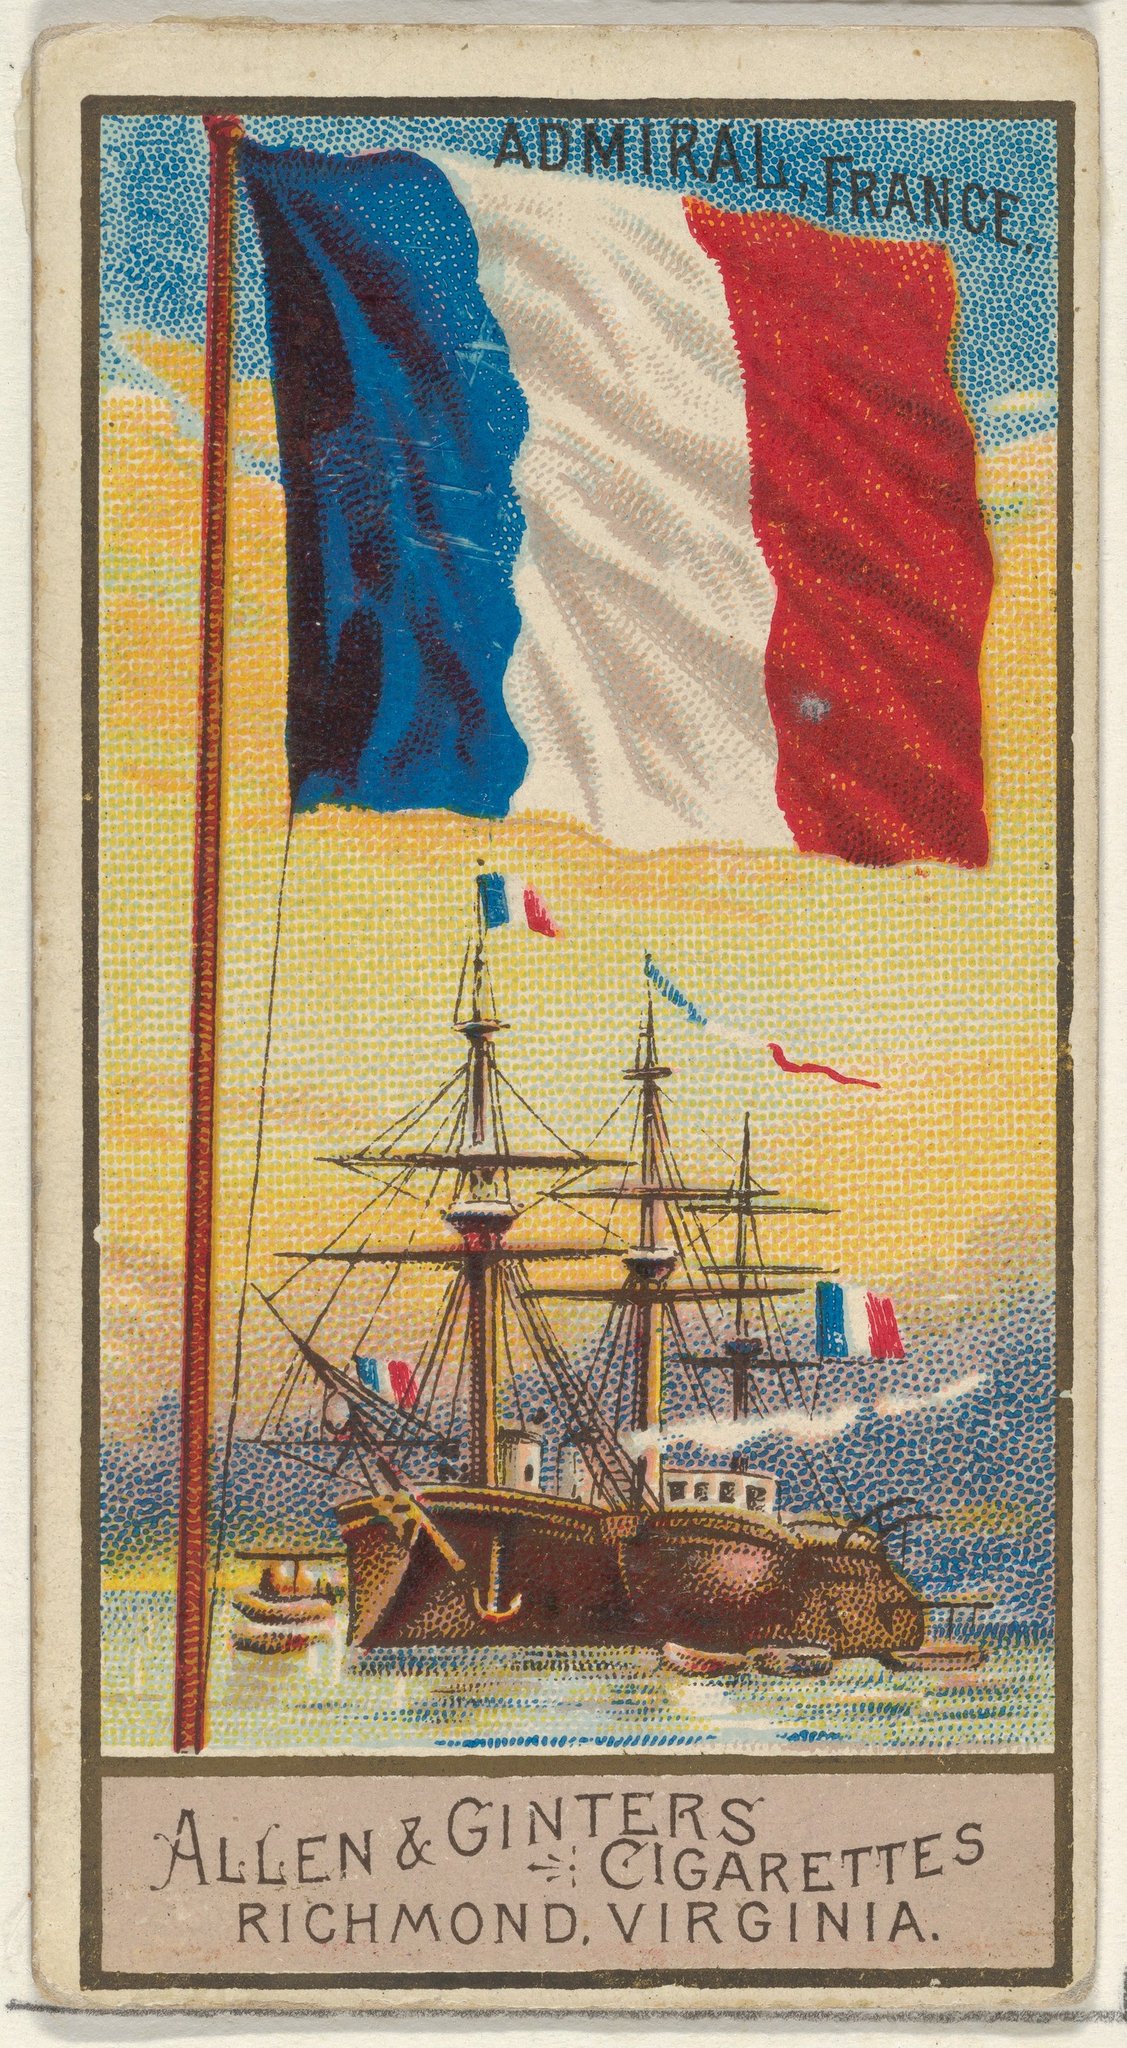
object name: print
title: Admiral, France, from the Naval Flags series (N17) for Allen & Ginter Cigarettes Brands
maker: allen & ginter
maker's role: publisher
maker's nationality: american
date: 1888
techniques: color lithograph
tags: flags,ships